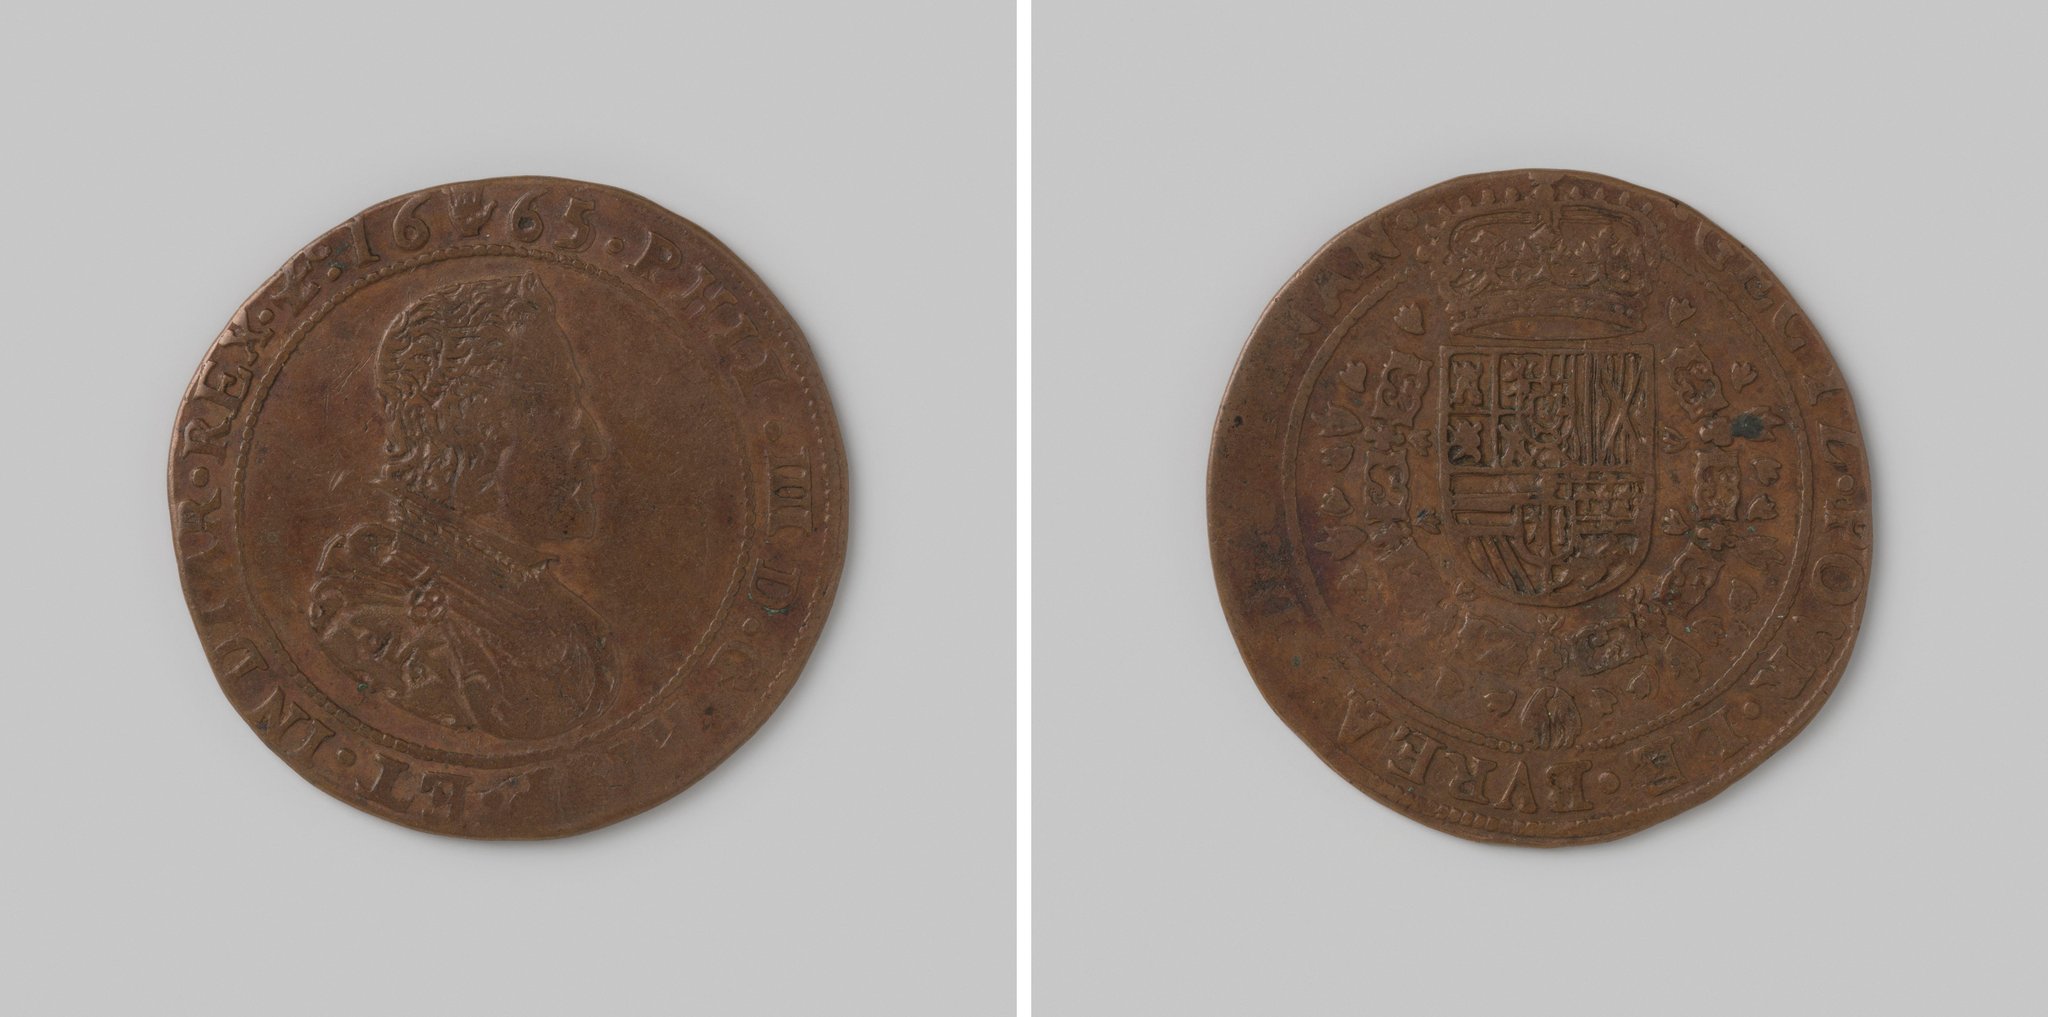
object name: jeton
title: Rekenpenning uit Antwerpen voor het Bureau van Financien 1665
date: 1665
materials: copper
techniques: striking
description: Koperen penning, op de voorzijde het borstbeeld van Philips IV naar rechts met omschrift, op de keerzijde het gekroonde Spaanse wapenschild omhangen met de keten van het gulden vlies, met omschrift.